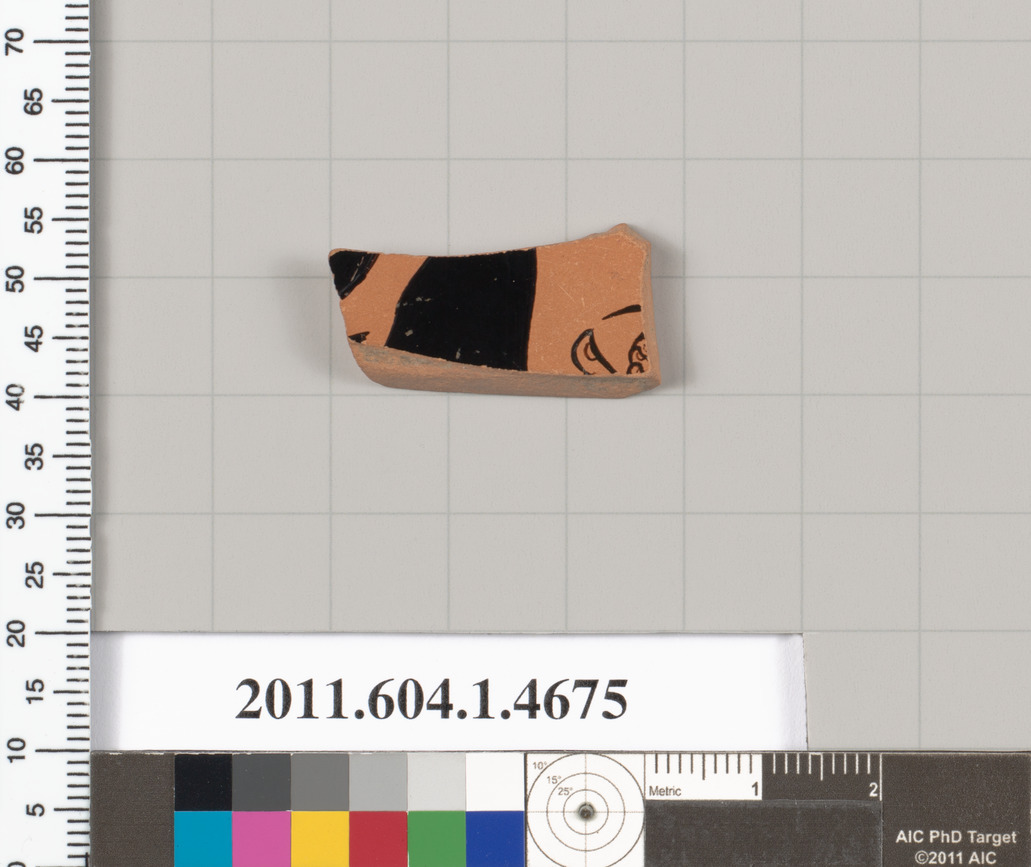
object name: kylix fragment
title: Terracotta fragment of a kylix (drinking cup)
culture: greek, attic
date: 490-470 BCE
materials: terracotta